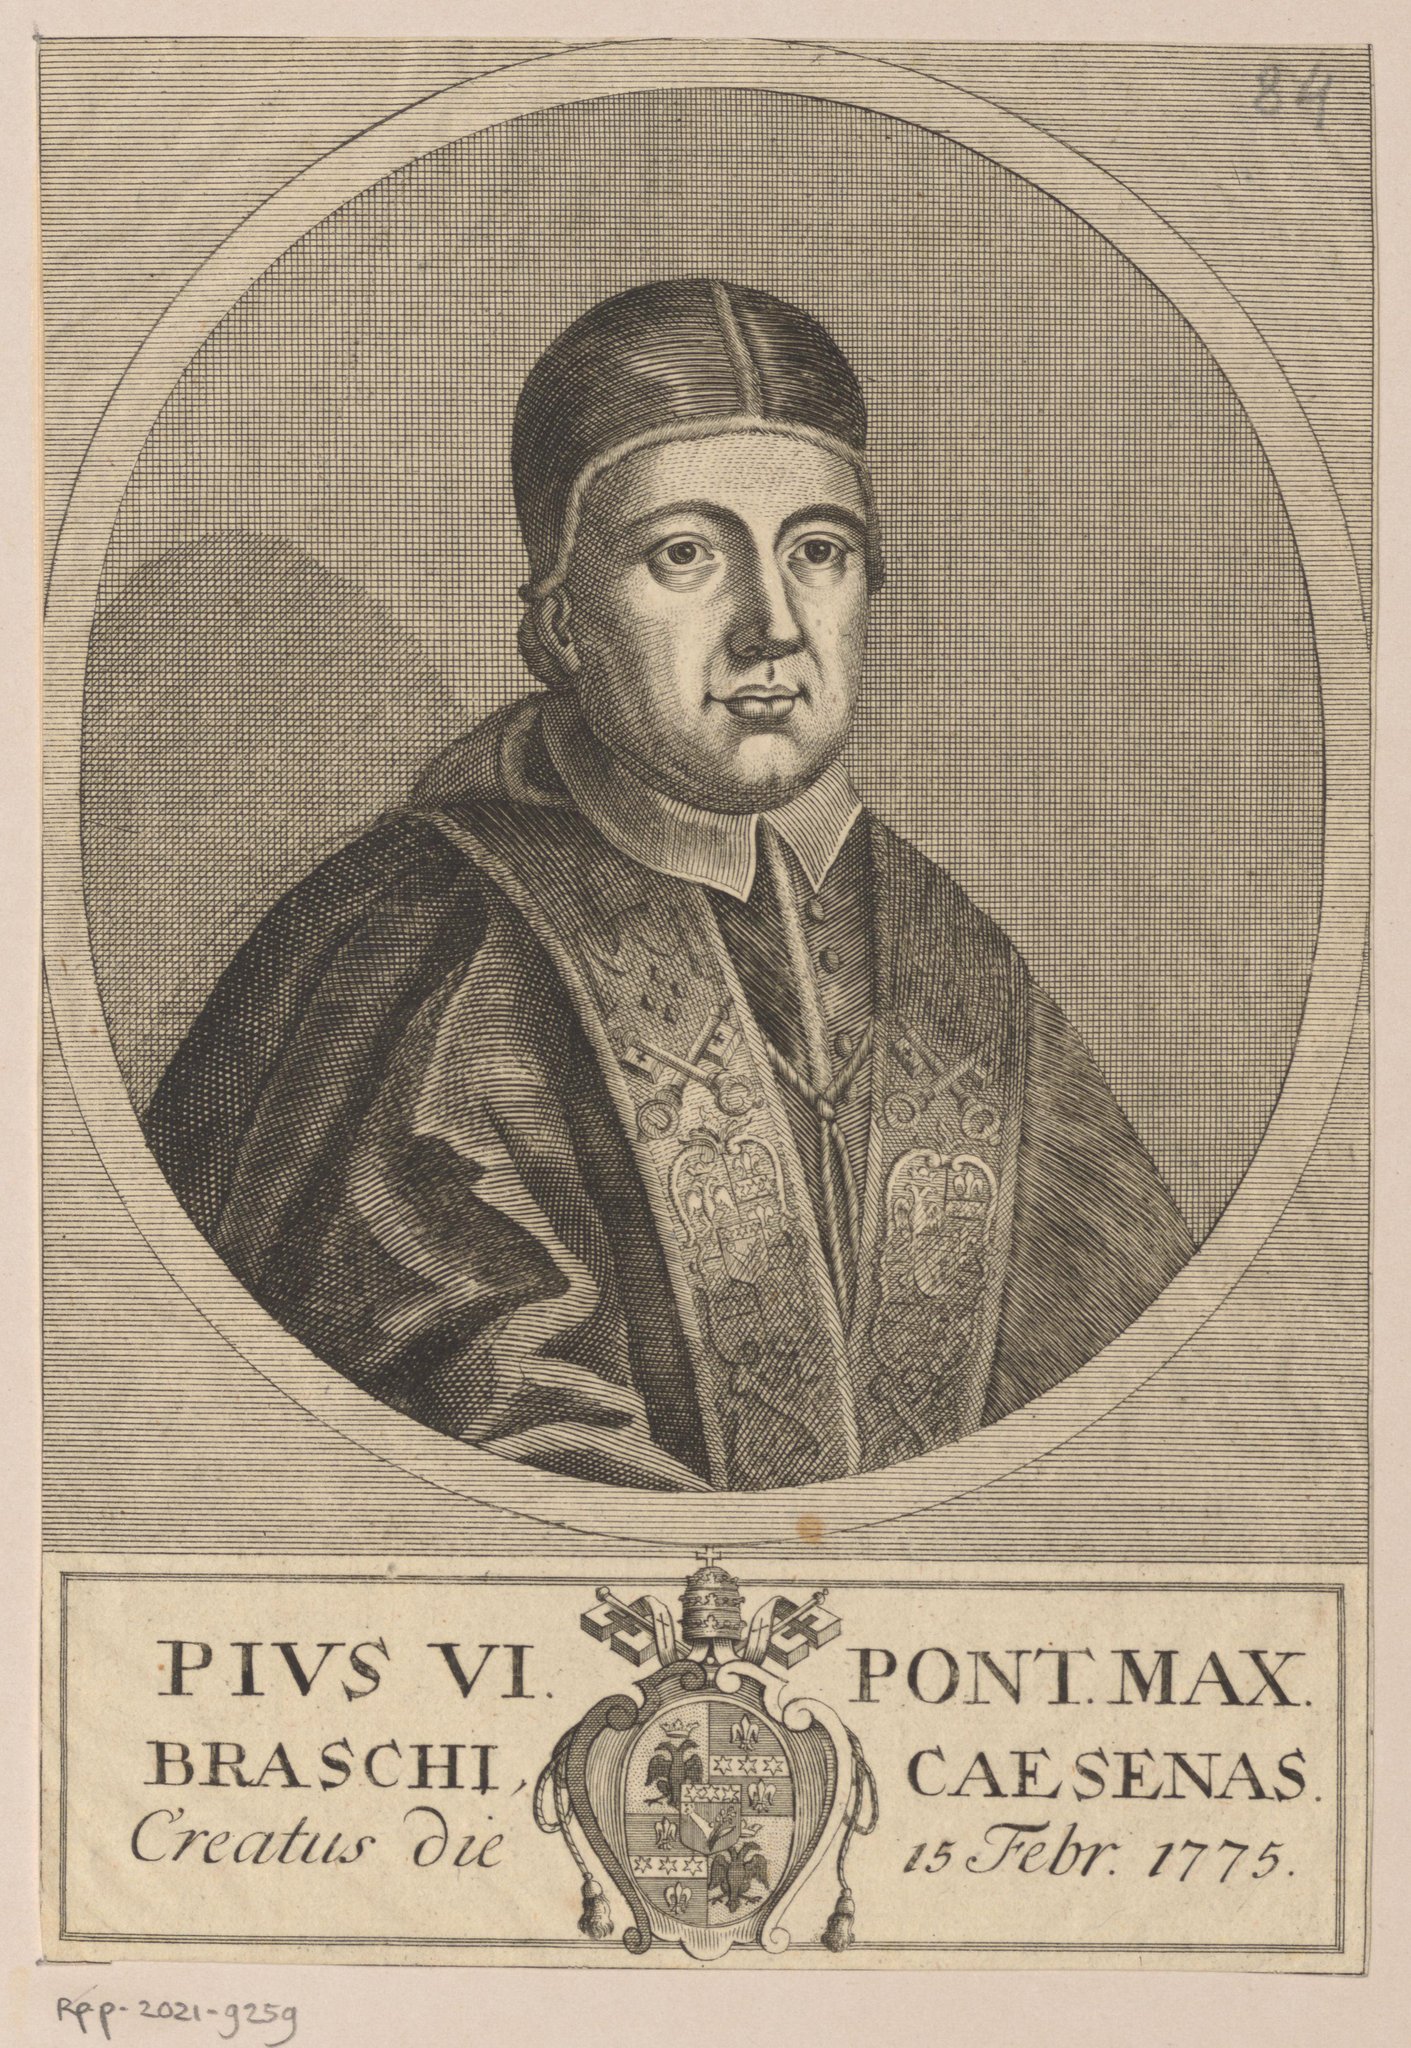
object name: print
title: Portret van paus Pius VI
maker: Anonymous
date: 1775-1824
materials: paper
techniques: engraving, etching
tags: pius vi, historical persons, pope, armorial bearing, heraldry